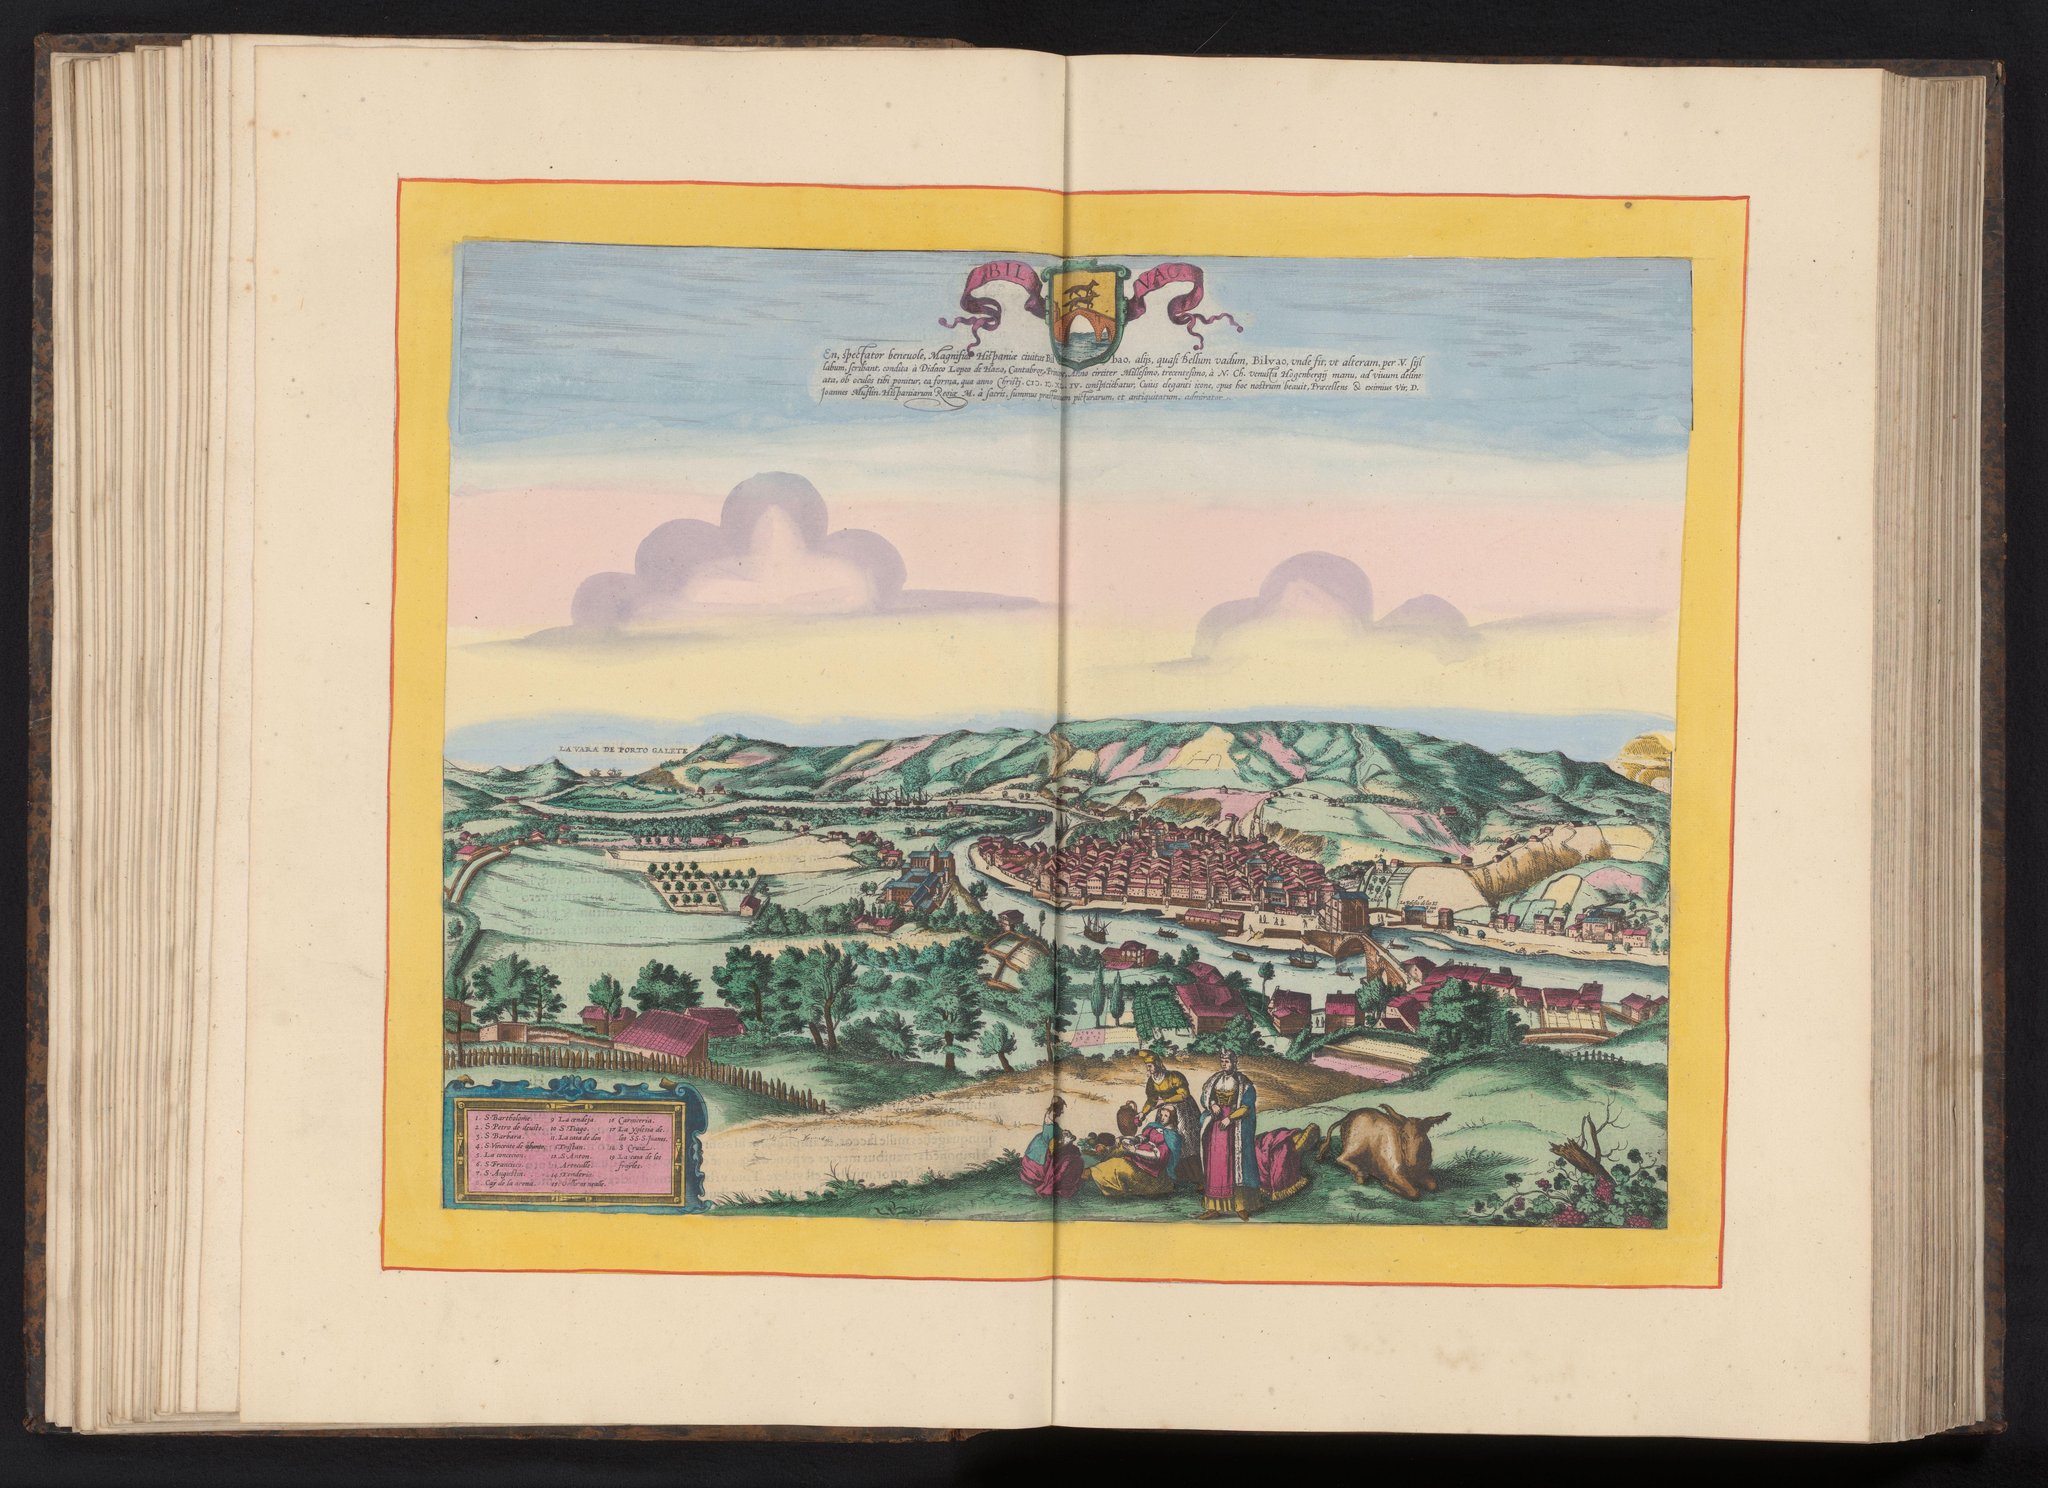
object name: print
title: Bilvao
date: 1544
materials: paper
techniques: engraving, etching, hand coloring, letterpress printing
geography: cologne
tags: city-view in general; 'veduta'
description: Prent origineel vervaardigd als boekillustratie voor: Georg Braun en Frans Hogenberg. Civitates Orbis Terrarum, 6 delen. Keulen: 1572-1617. De prent werd voor het eerst gepubliceerd in deel 2: De praecipuis totius universi urbibus liber secundus, 1575. De prent is langs de bovenrand van de heuvels afgescheurd. Het bovenste gedeelte met de lucht is hoger opgeplakt, zodat de lucht hoger is geworden en het formaat van de voorstelling past bij de andere groot formaatvoorstellingen in het album.